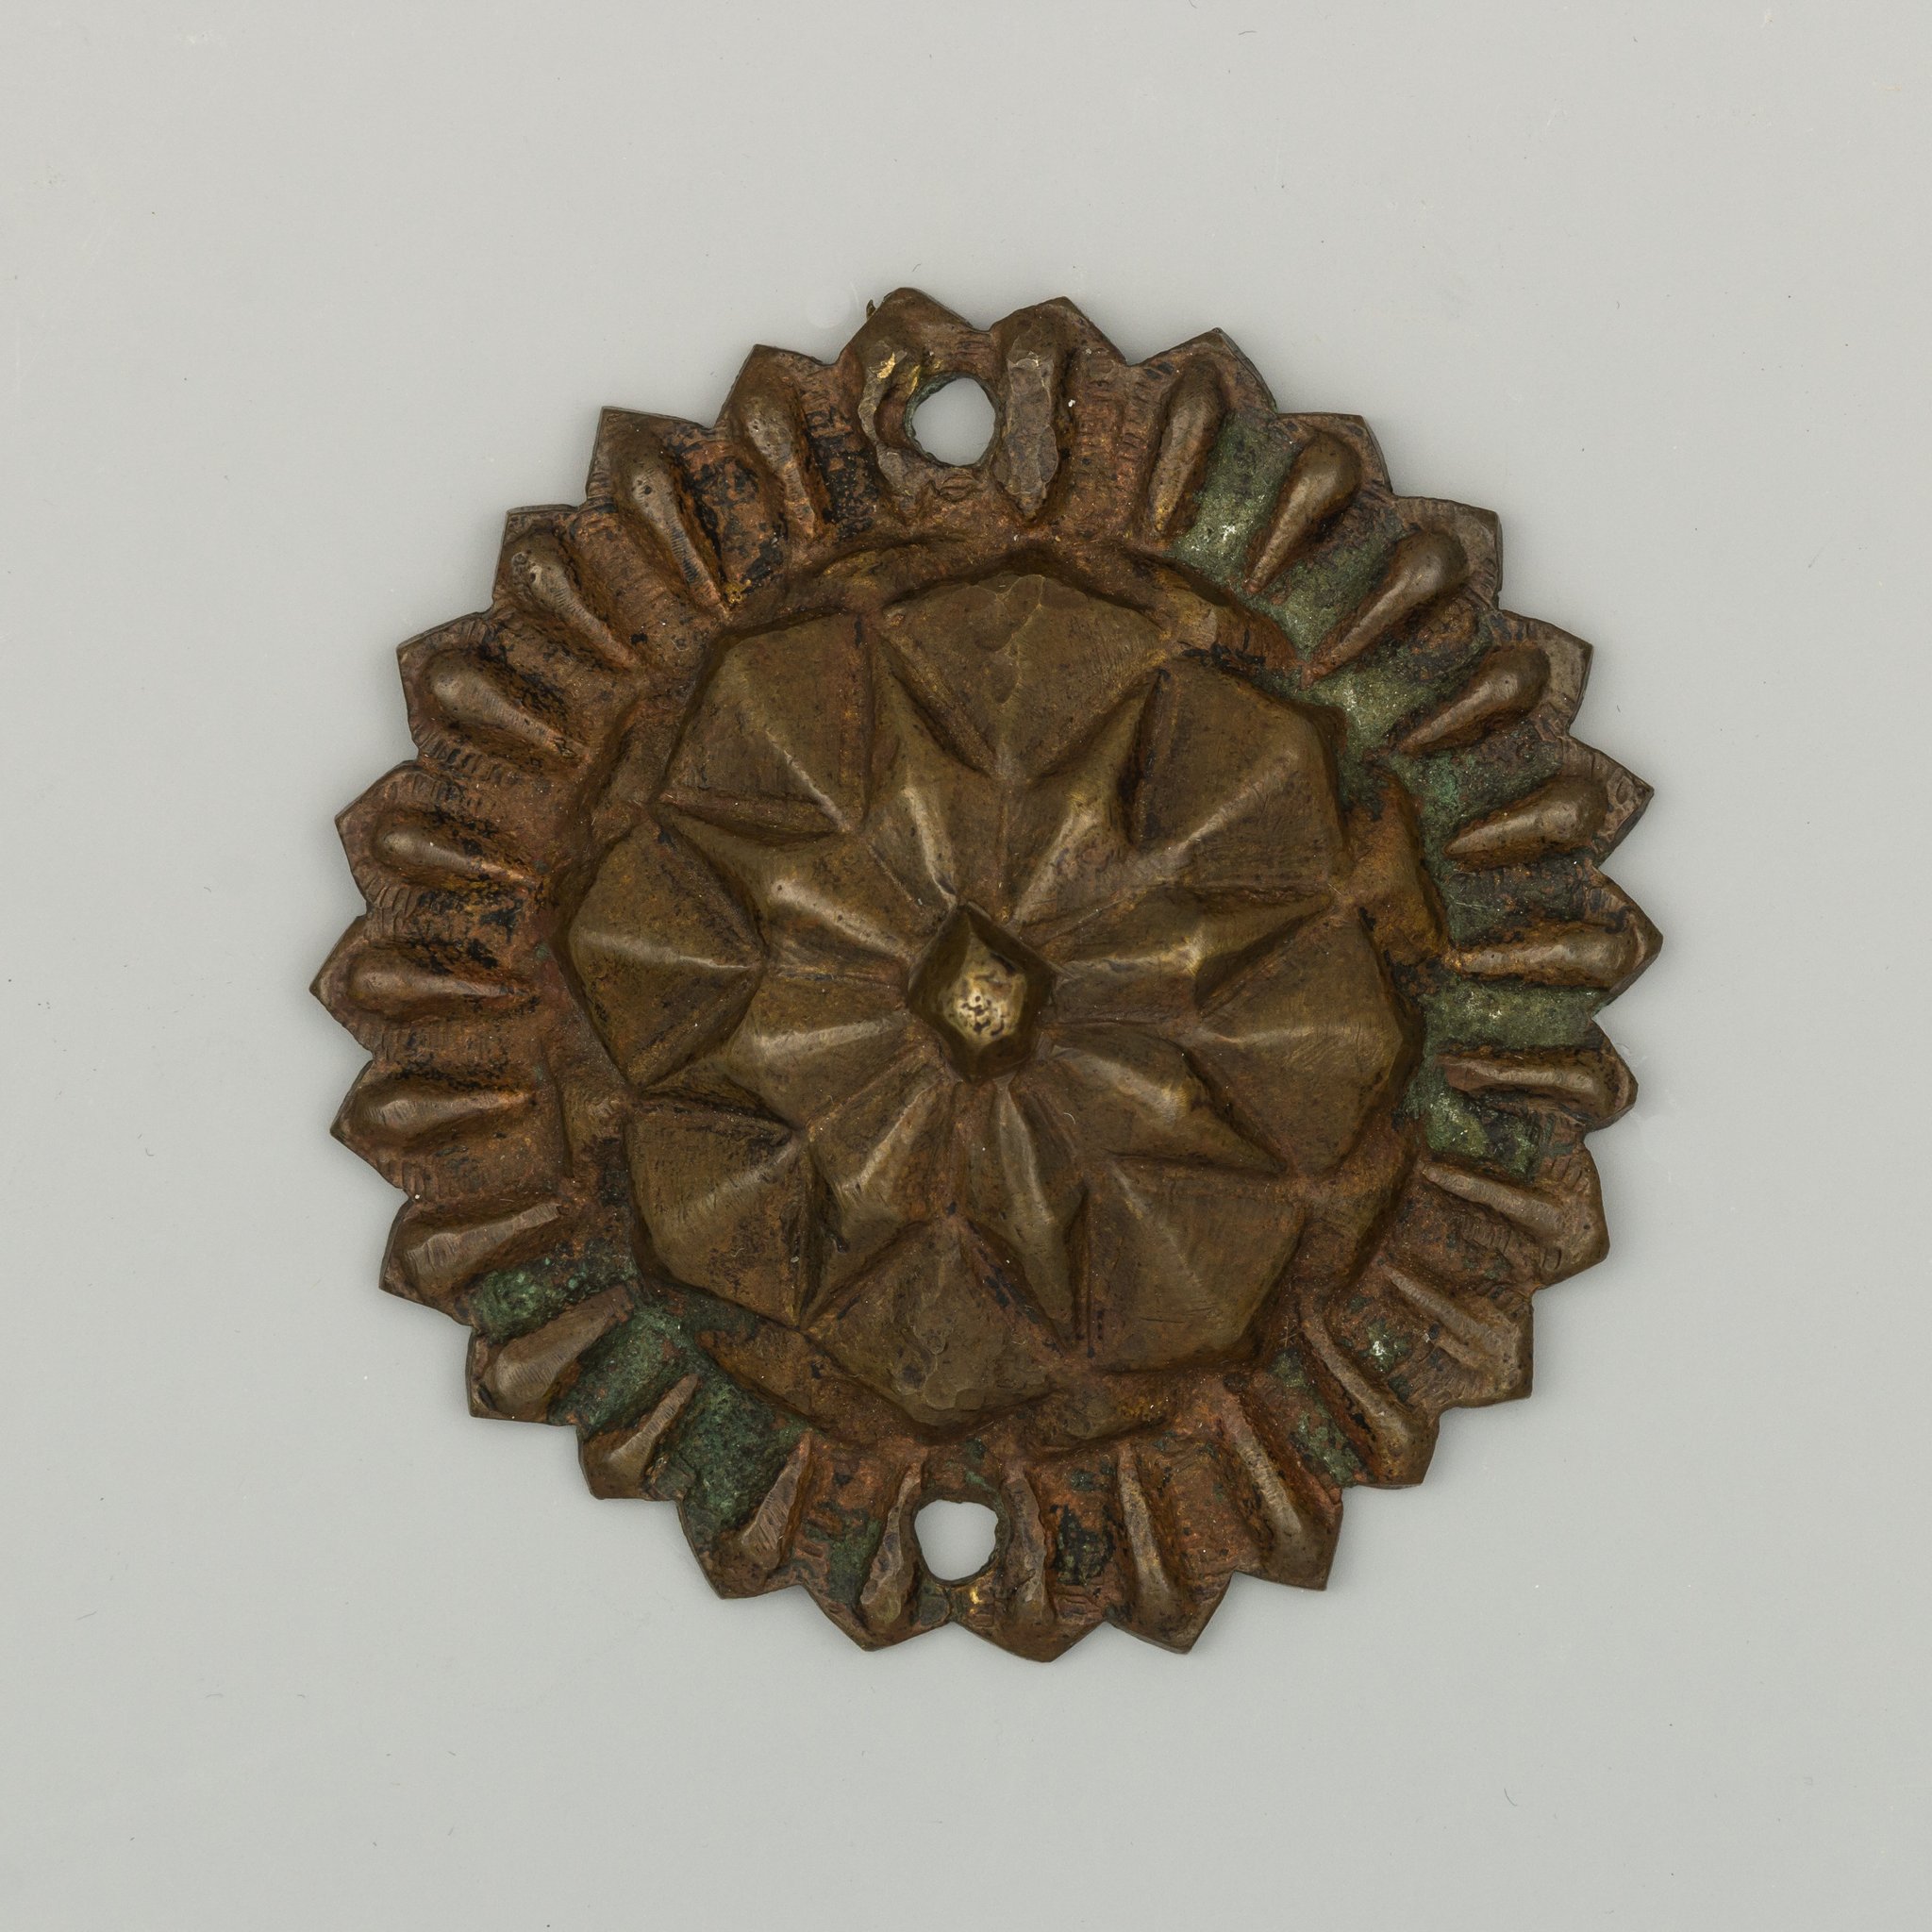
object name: bit bos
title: Pair of Bit Bosses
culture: dutch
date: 1601-1650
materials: copper alloy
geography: netherlands